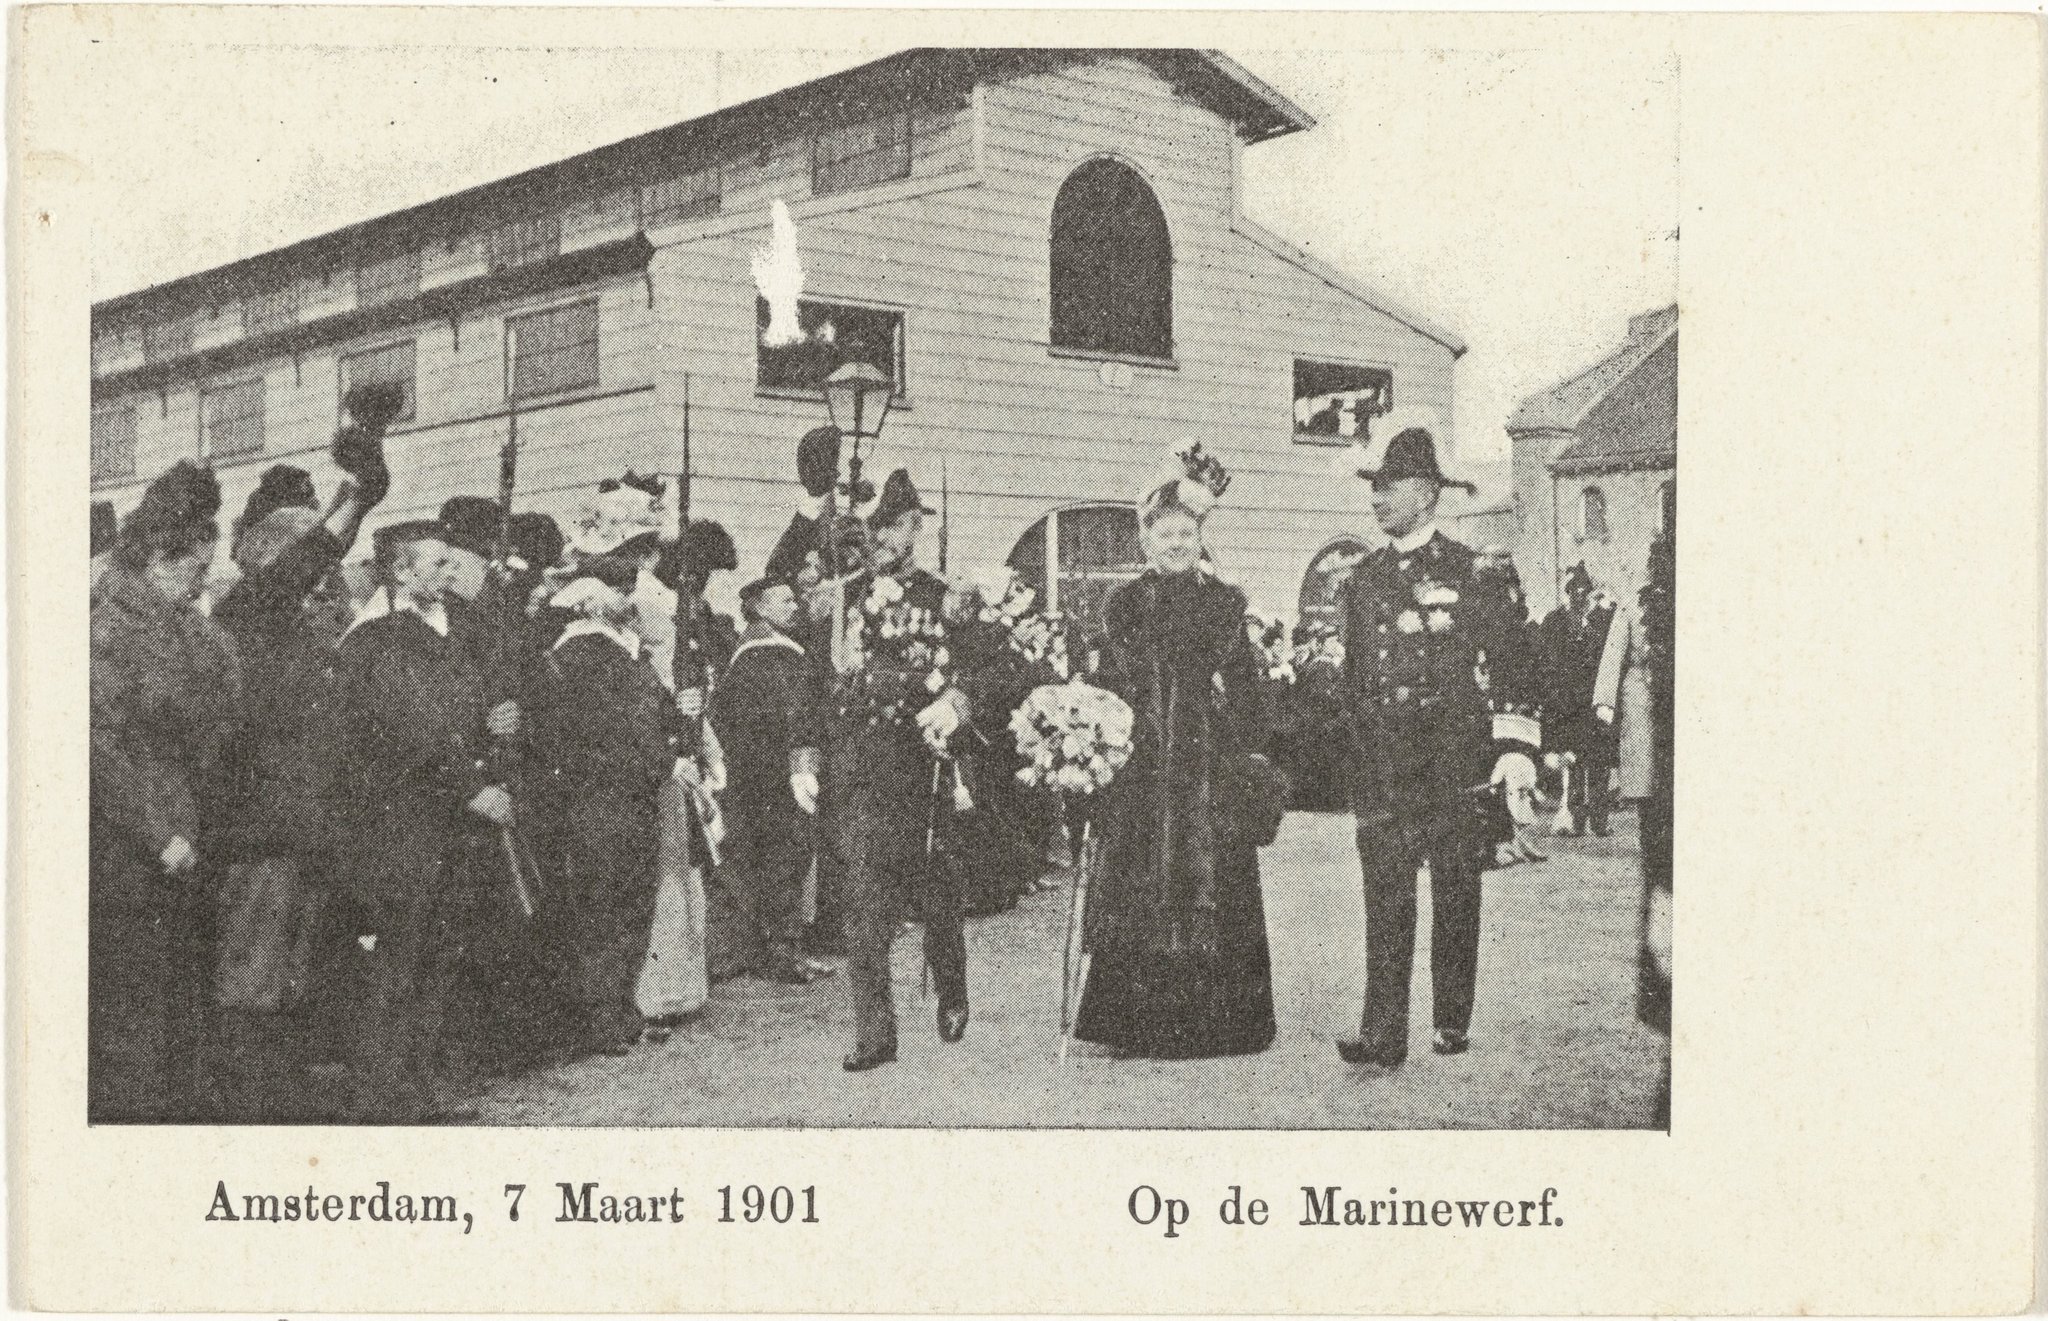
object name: ansichtkaart, prentbriefkaart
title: Bezoek van Wilhelmina, koningin der Nederlanden, en Hendrik van Mecklenburg-Schwerin aan de marinewerf te Amsterdam op 7 maart 1901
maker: Anonymous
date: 1901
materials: paper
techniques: autotype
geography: netherlands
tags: the hague, print maker, wilhelmina of the netherlands, hendrik (prins der nederlanden (1876-1934)), amsterdam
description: De hier vermelde titel verwijst naar de hoogst verkregen titel van de geportretteerde, niet per se naar de titel die de geportretteerde op deze voorstelling draagt.